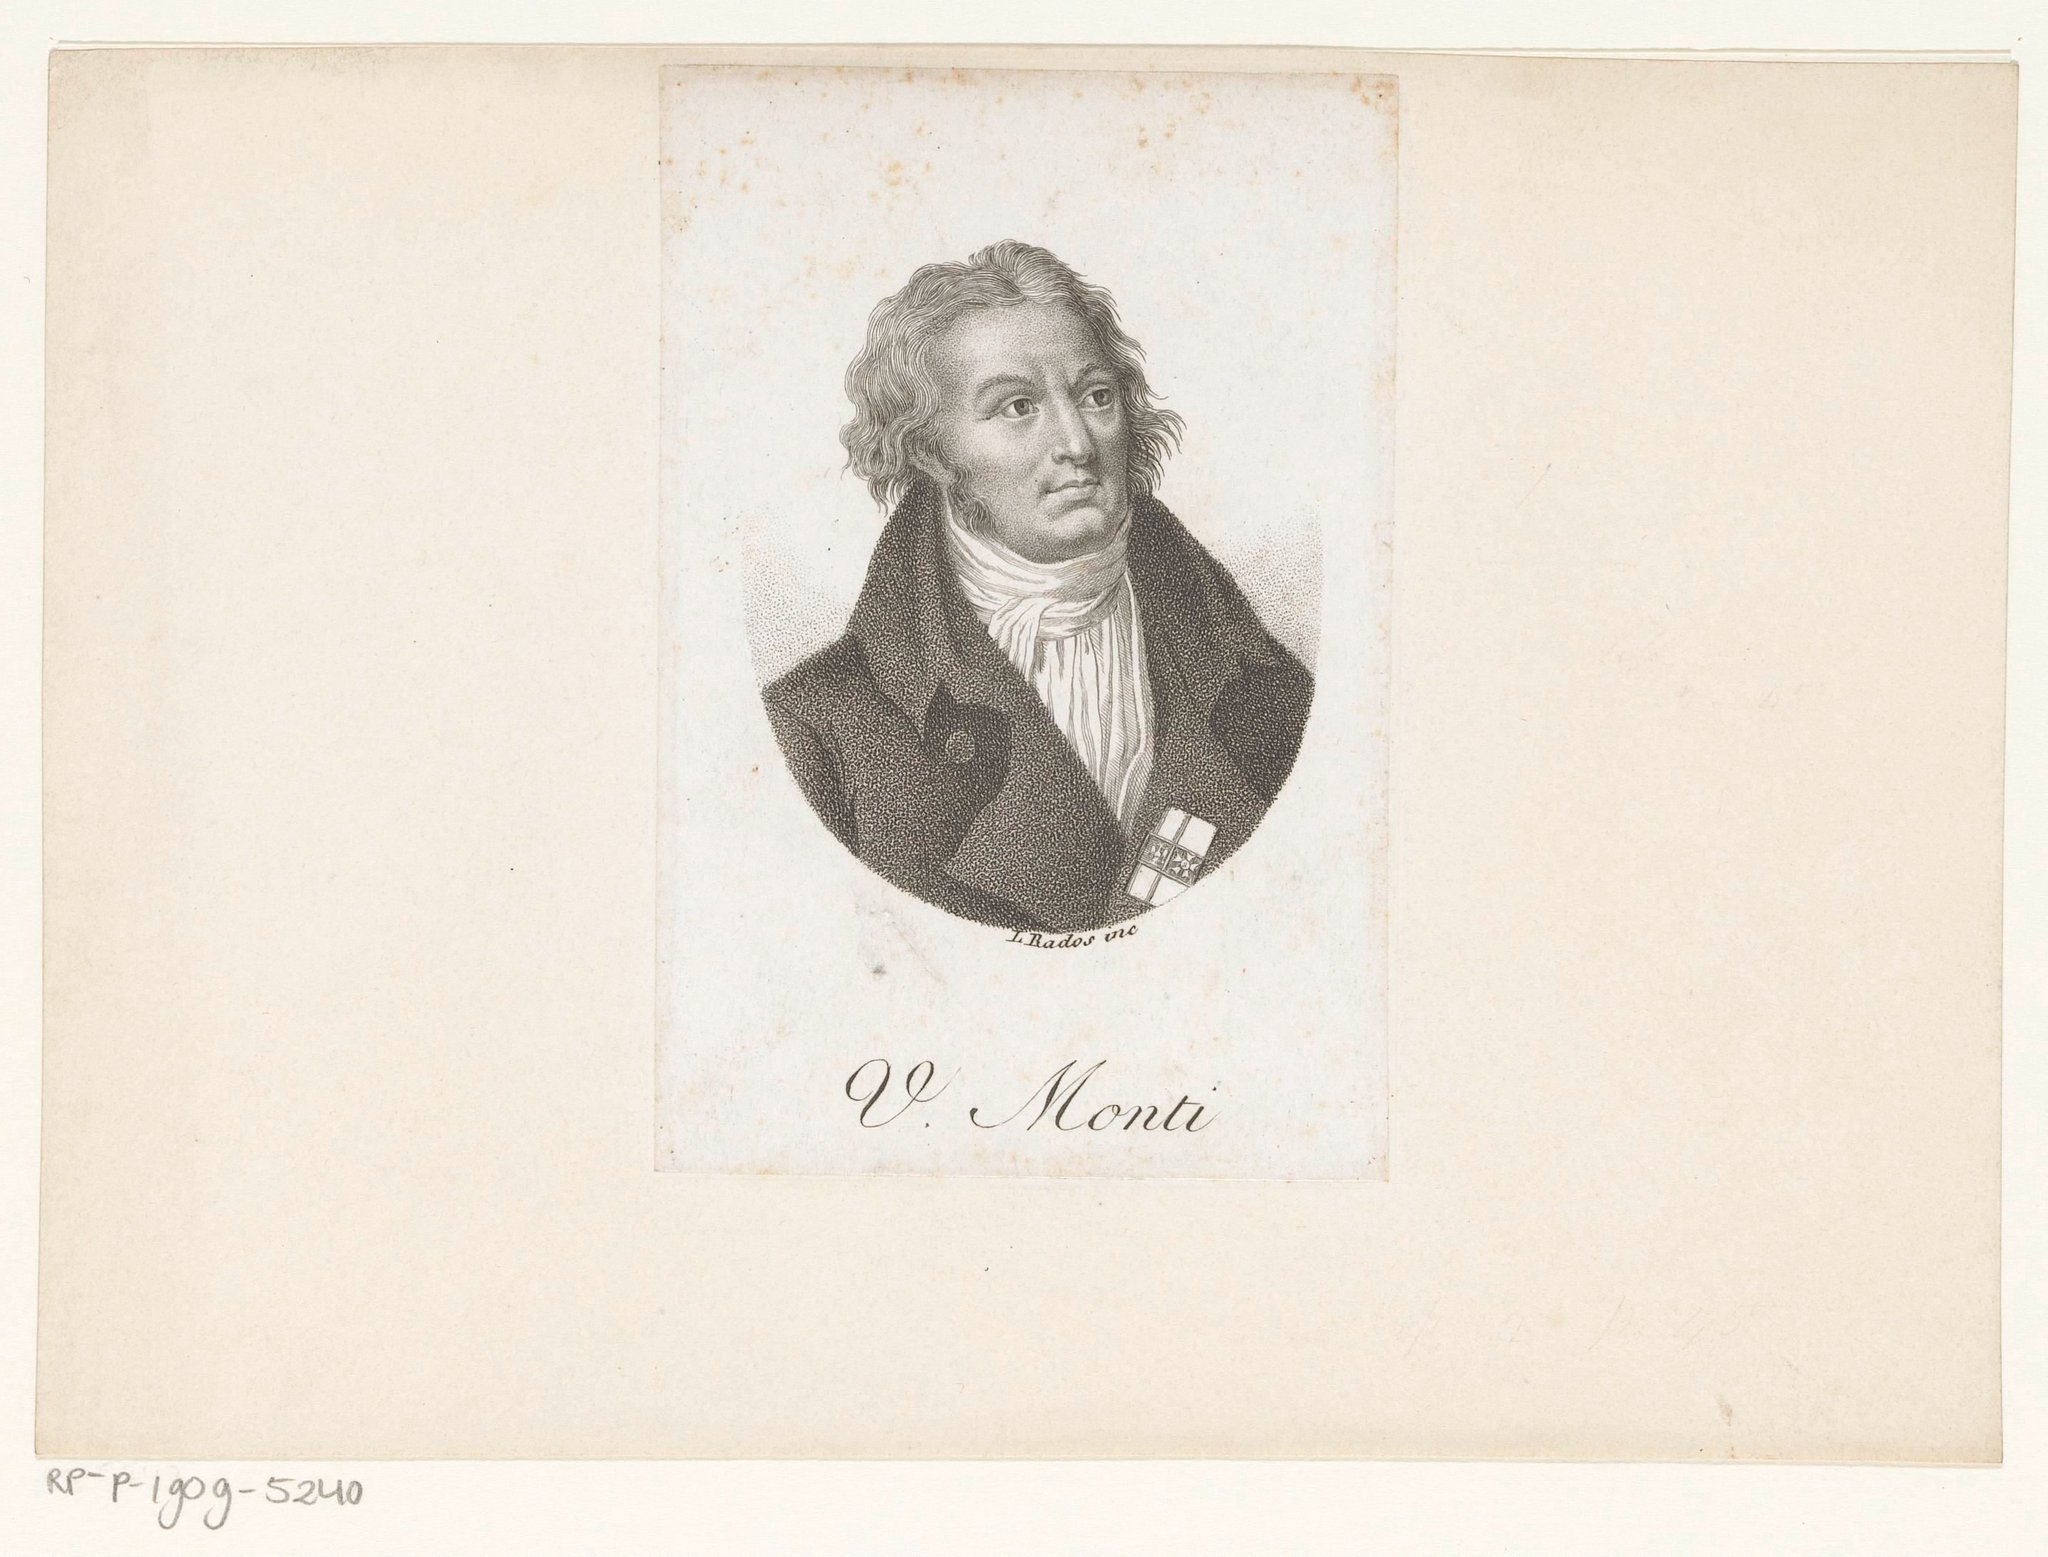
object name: print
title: Portret van schrijver Vincenzo Monti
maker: luigi rados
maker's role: print maker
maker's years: 1773-1840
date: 1783-1840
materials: paper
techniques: etching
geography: italy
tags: historical persons, portrait of a writer, writer, poet, author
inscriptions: collector's mark: Lugt 2228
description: Naar een schilderij door Andrea Appiani in de Pinacoteca di Brera te Milaan.